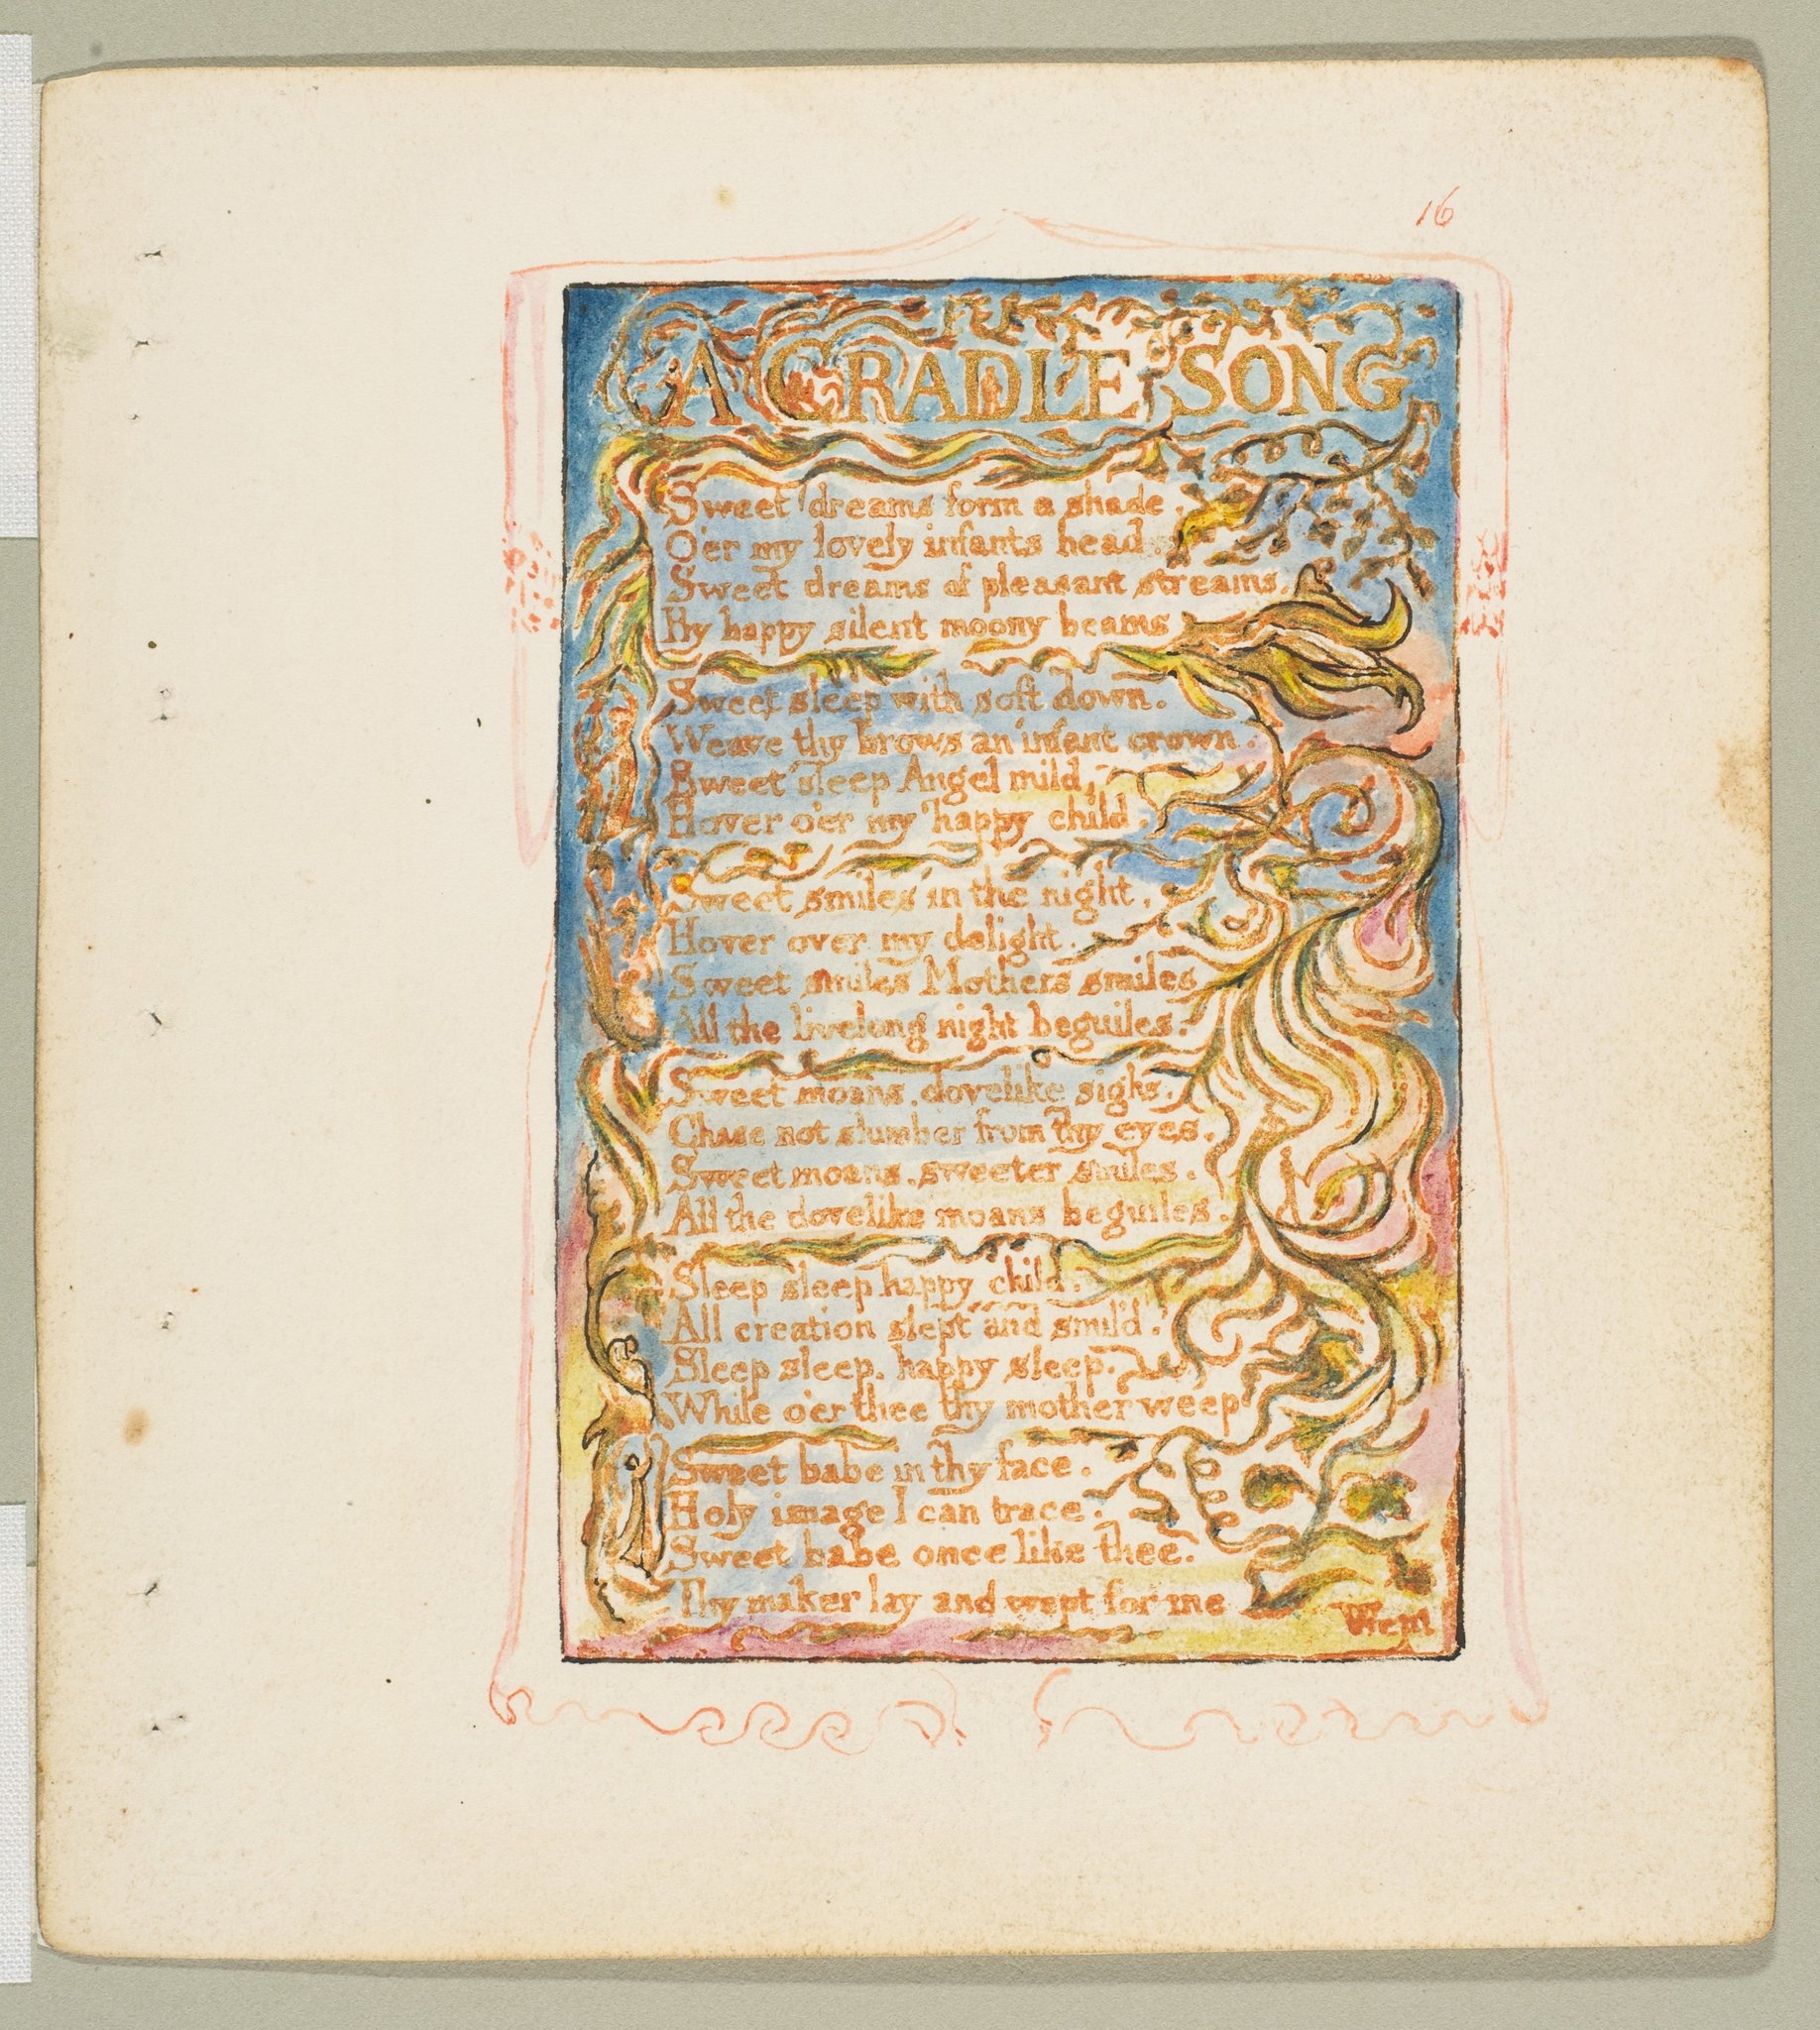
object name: print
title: Songs of Innocence: A Cradle Song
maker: william blake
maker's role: artist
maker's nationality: british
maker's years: 1757-1827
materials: gold, ink, shell, watercolor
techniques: etching, hand coloring, printing, relief